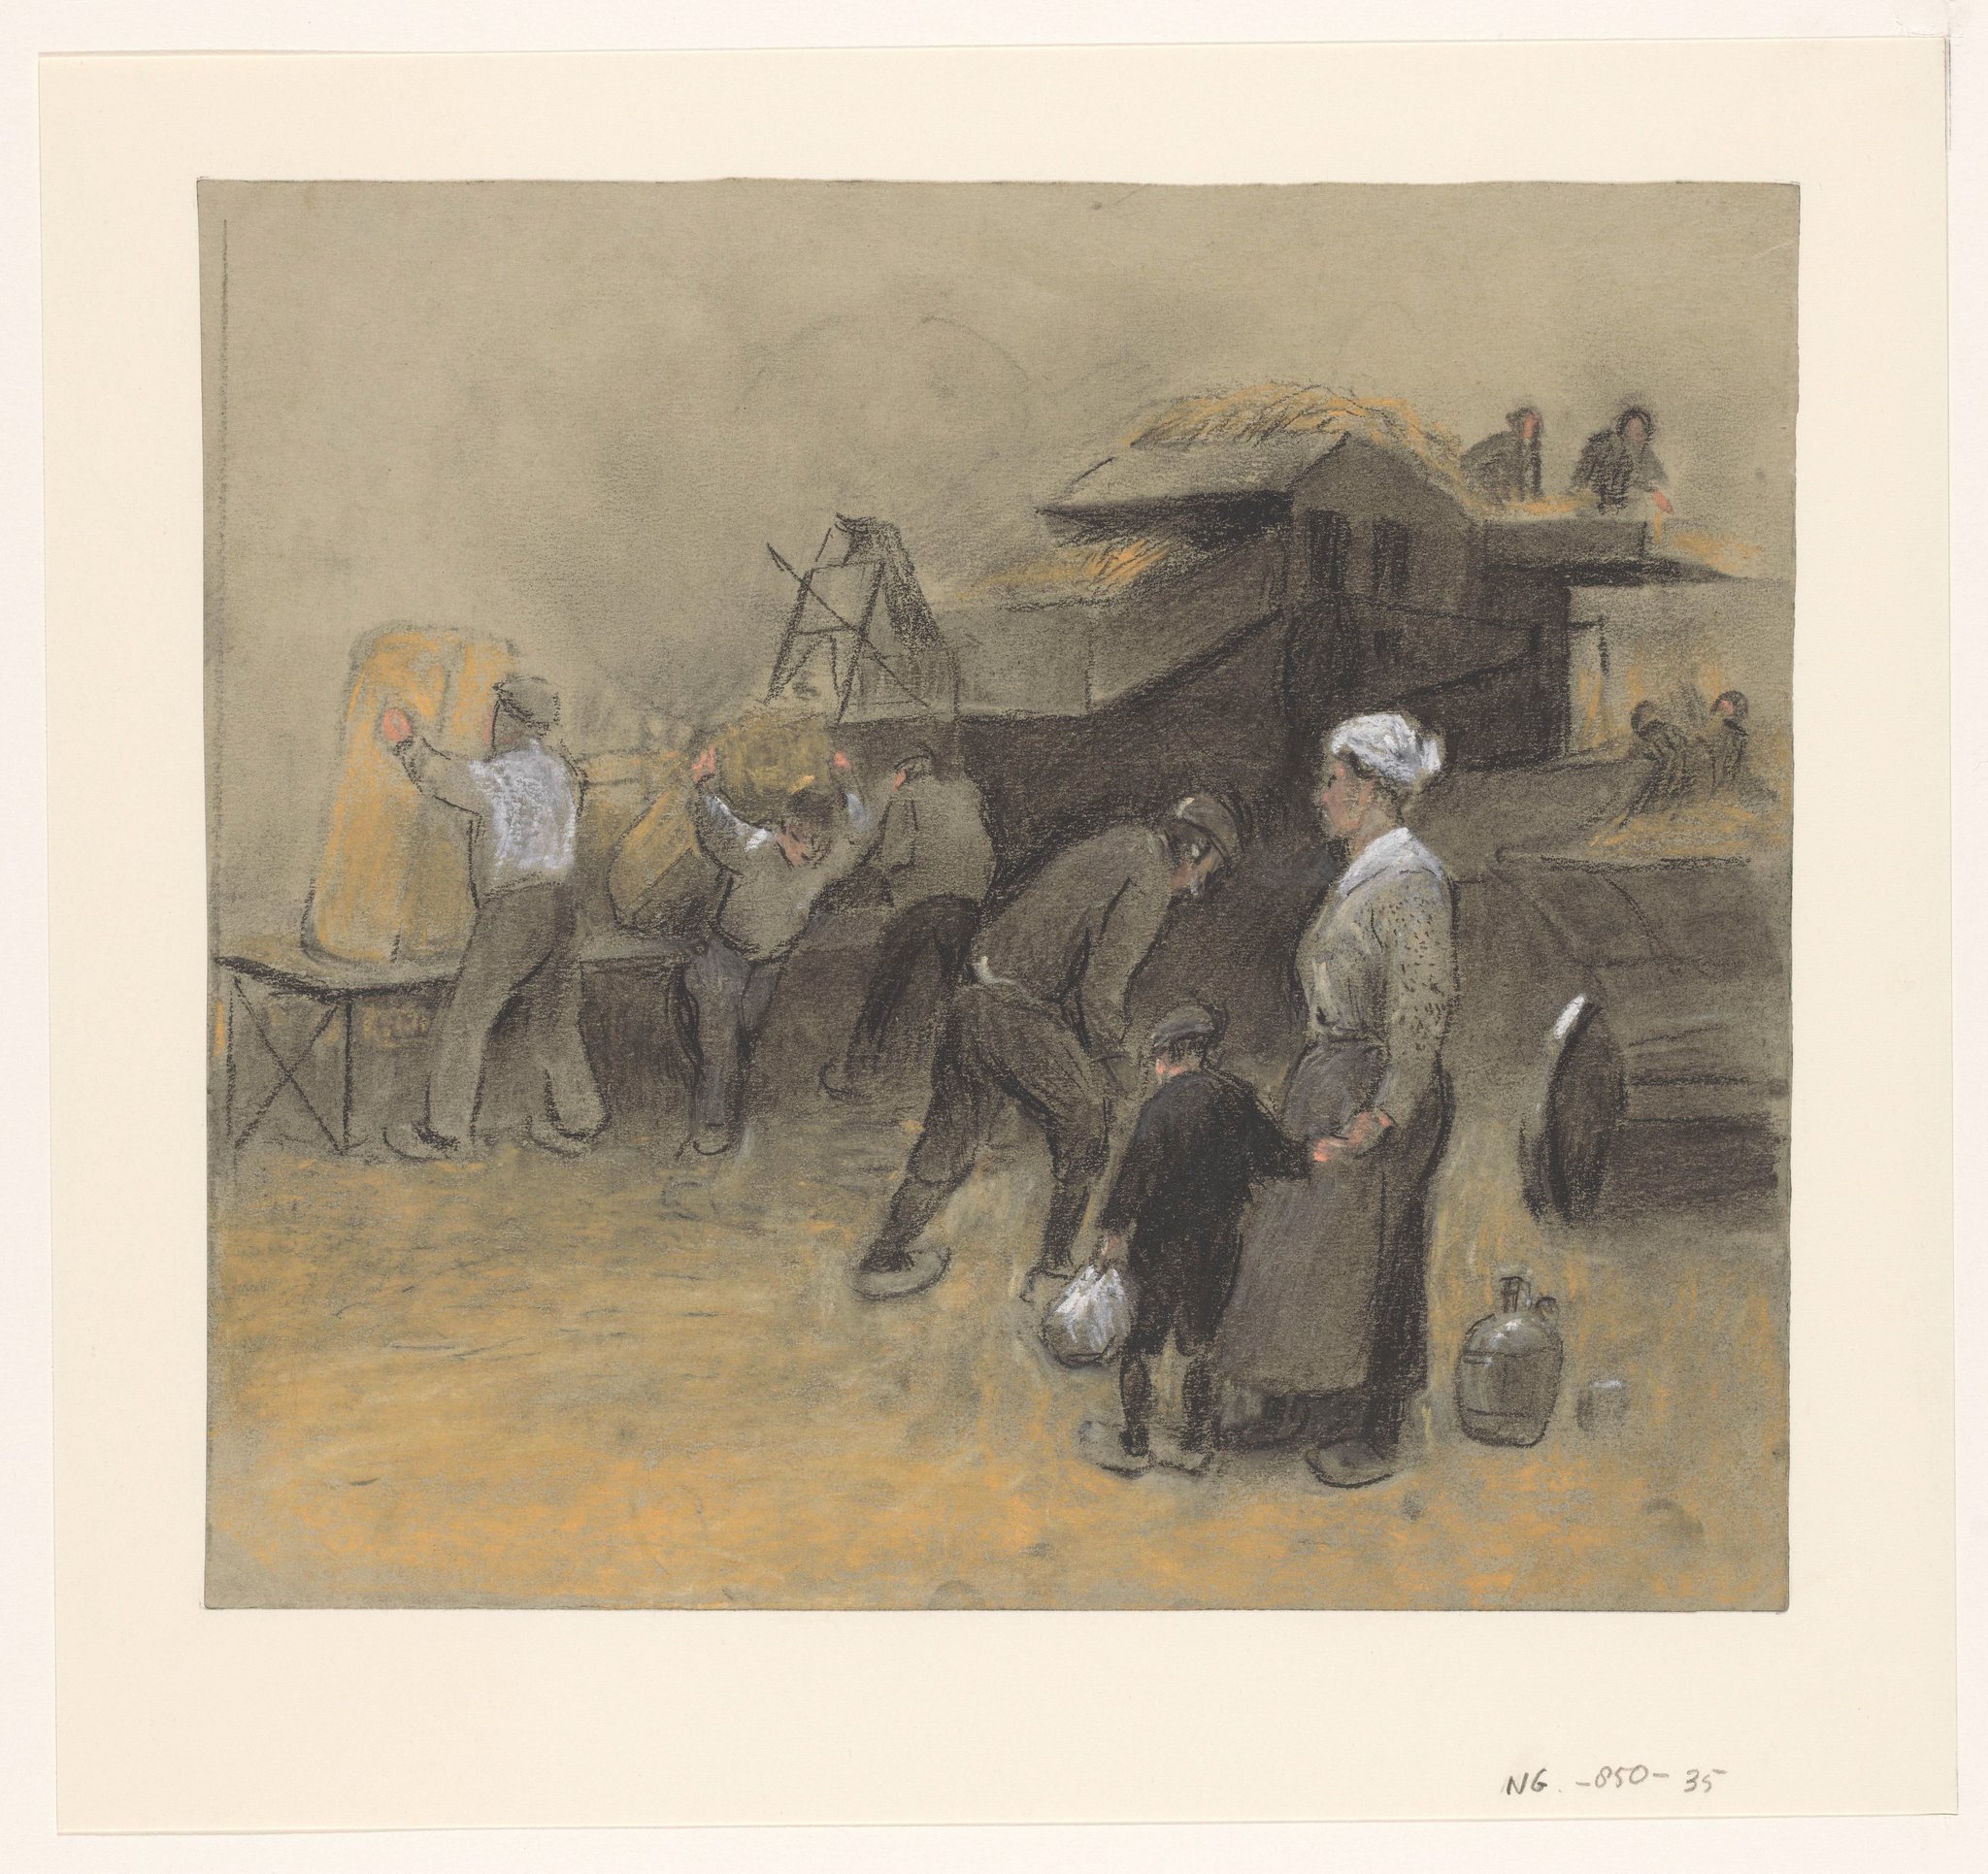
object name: drawing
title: Graanoogst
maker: herman heijenbrock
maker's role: draughtsman, painter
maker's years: 1871-1948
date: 1900-1925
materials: chalk, paper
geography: netherlands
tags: harvest, netherlands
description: Graanoogst. Drie boeren bezig balen stro van een grote tafel te verwijderen. De balen komen uit een landbouwmachine waarop de silhouetten van twee andere boeren te onderscheiden zijn. Op de voorgrond een kind en een boerin, hand in hand. Achter de boerin staat een kruik en een pul. Op de keerzijde een aanzet in potlood van een architectuurtekening.